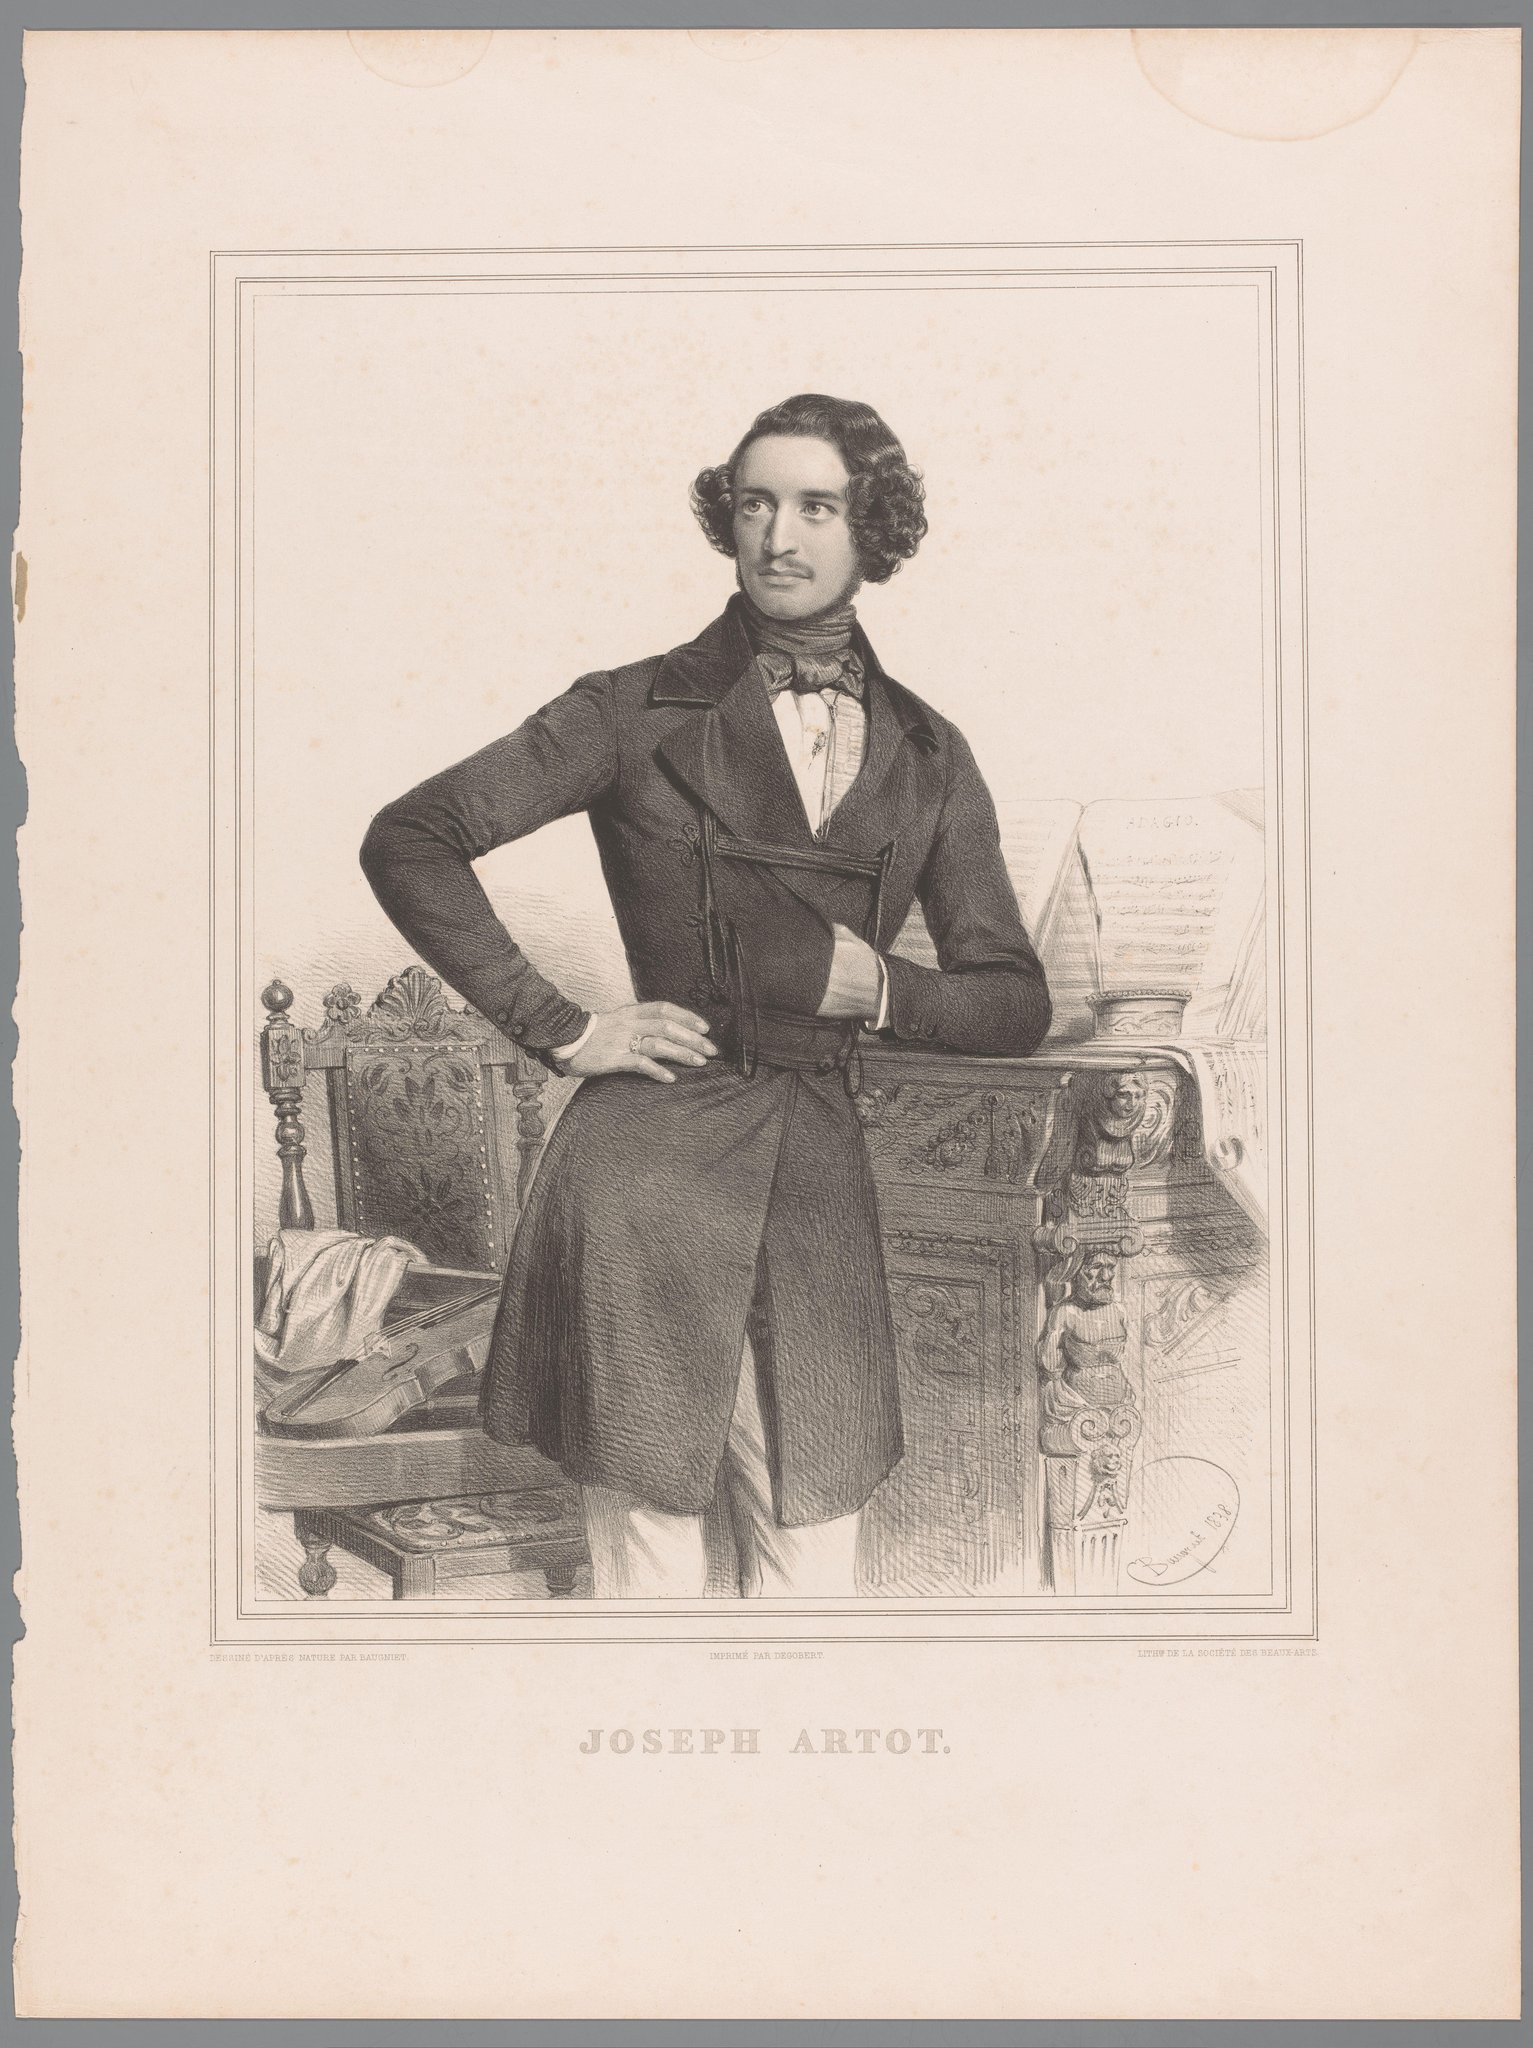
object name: print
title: Portret van Alexandre-Joseph Artot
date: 1838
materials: paper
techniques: lithograph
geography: brussels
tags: brussels, adult man, historical persons, violin, fiddle, portrait of a musician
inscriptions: collector's mark: Lugt 2228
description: Prent verschenen in: Baugniet, Charles. Les artistes contemporains: portraits lithographiés d'après nature, accompagnés de notices sur la vie et les ouvrages de chacun d'eux. Brussel: De Wasme-Pletinckx, [1836-1840].